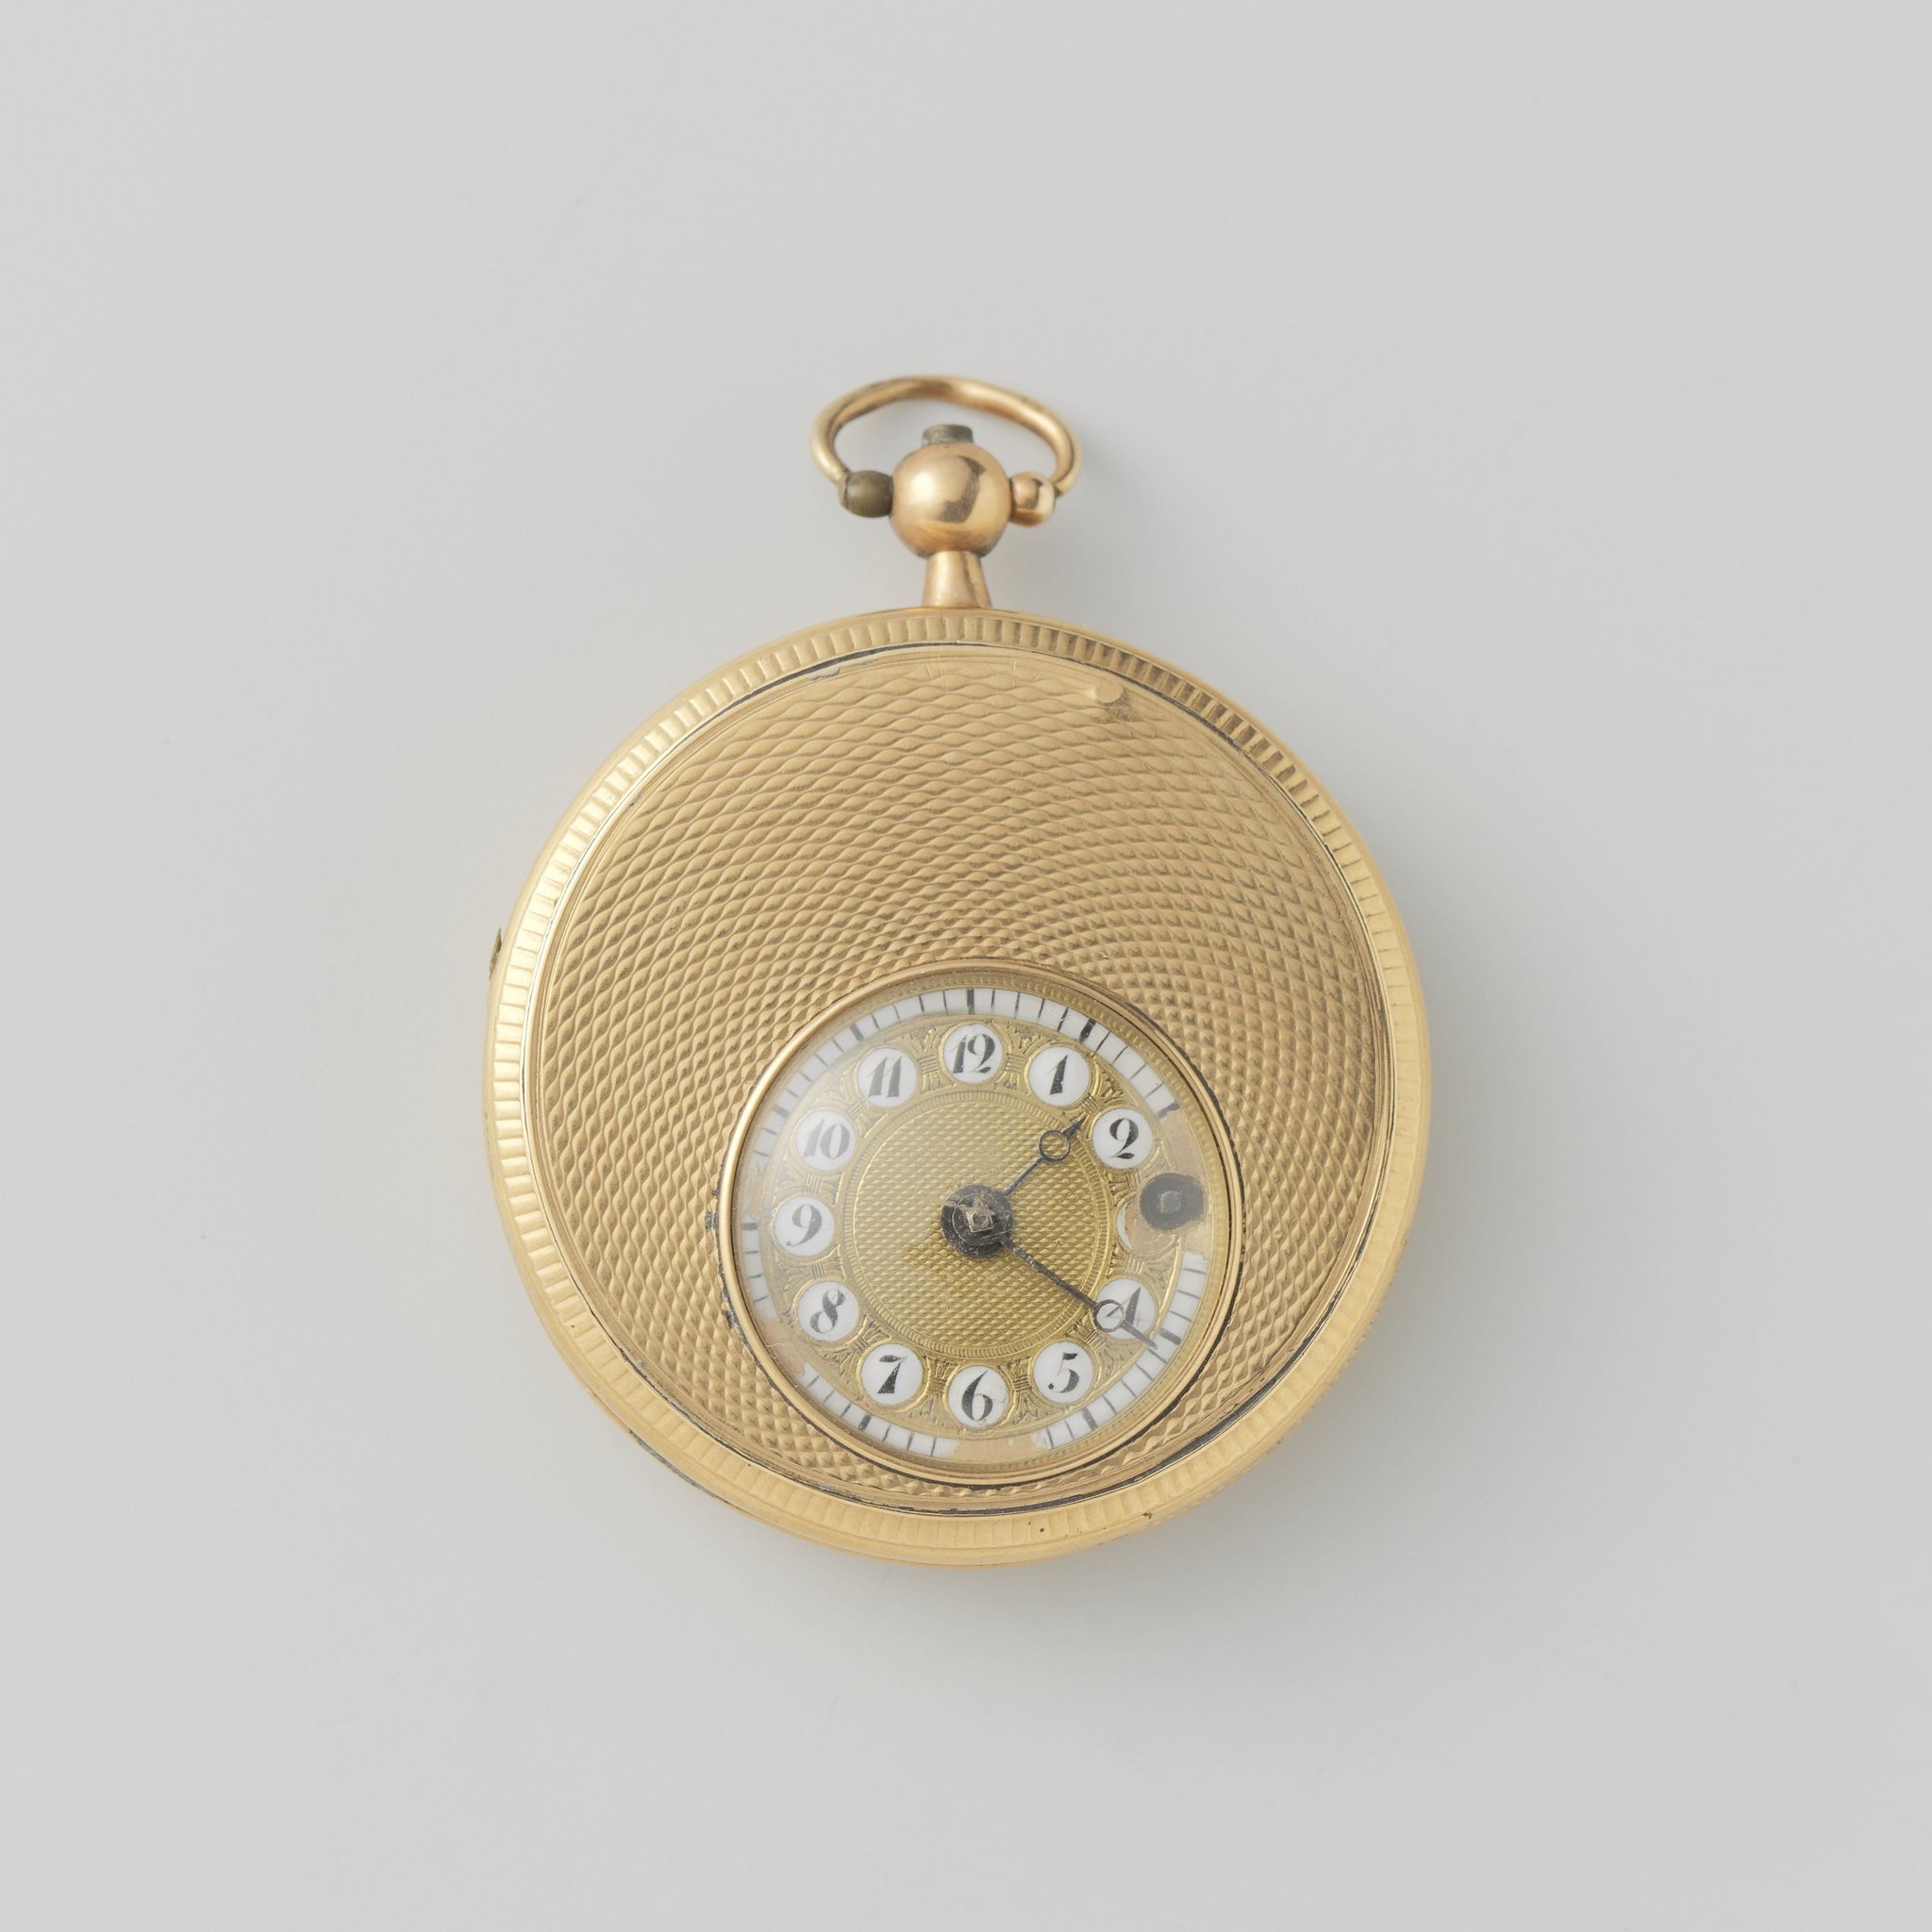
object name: jewellery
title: Watch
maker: Anonymous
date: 1815-1820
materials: gold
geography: switzerland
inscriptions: signature: ‘VACHERON CH[...} CE A GENEVE’, silver mark, signature: ‘Vacheron Chossat & Ce A GENEVE N 8350’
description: Gouden horloge met een gearceerde wijzerplaat met kleine cijferring. De achterbodem is geguillocheerd.